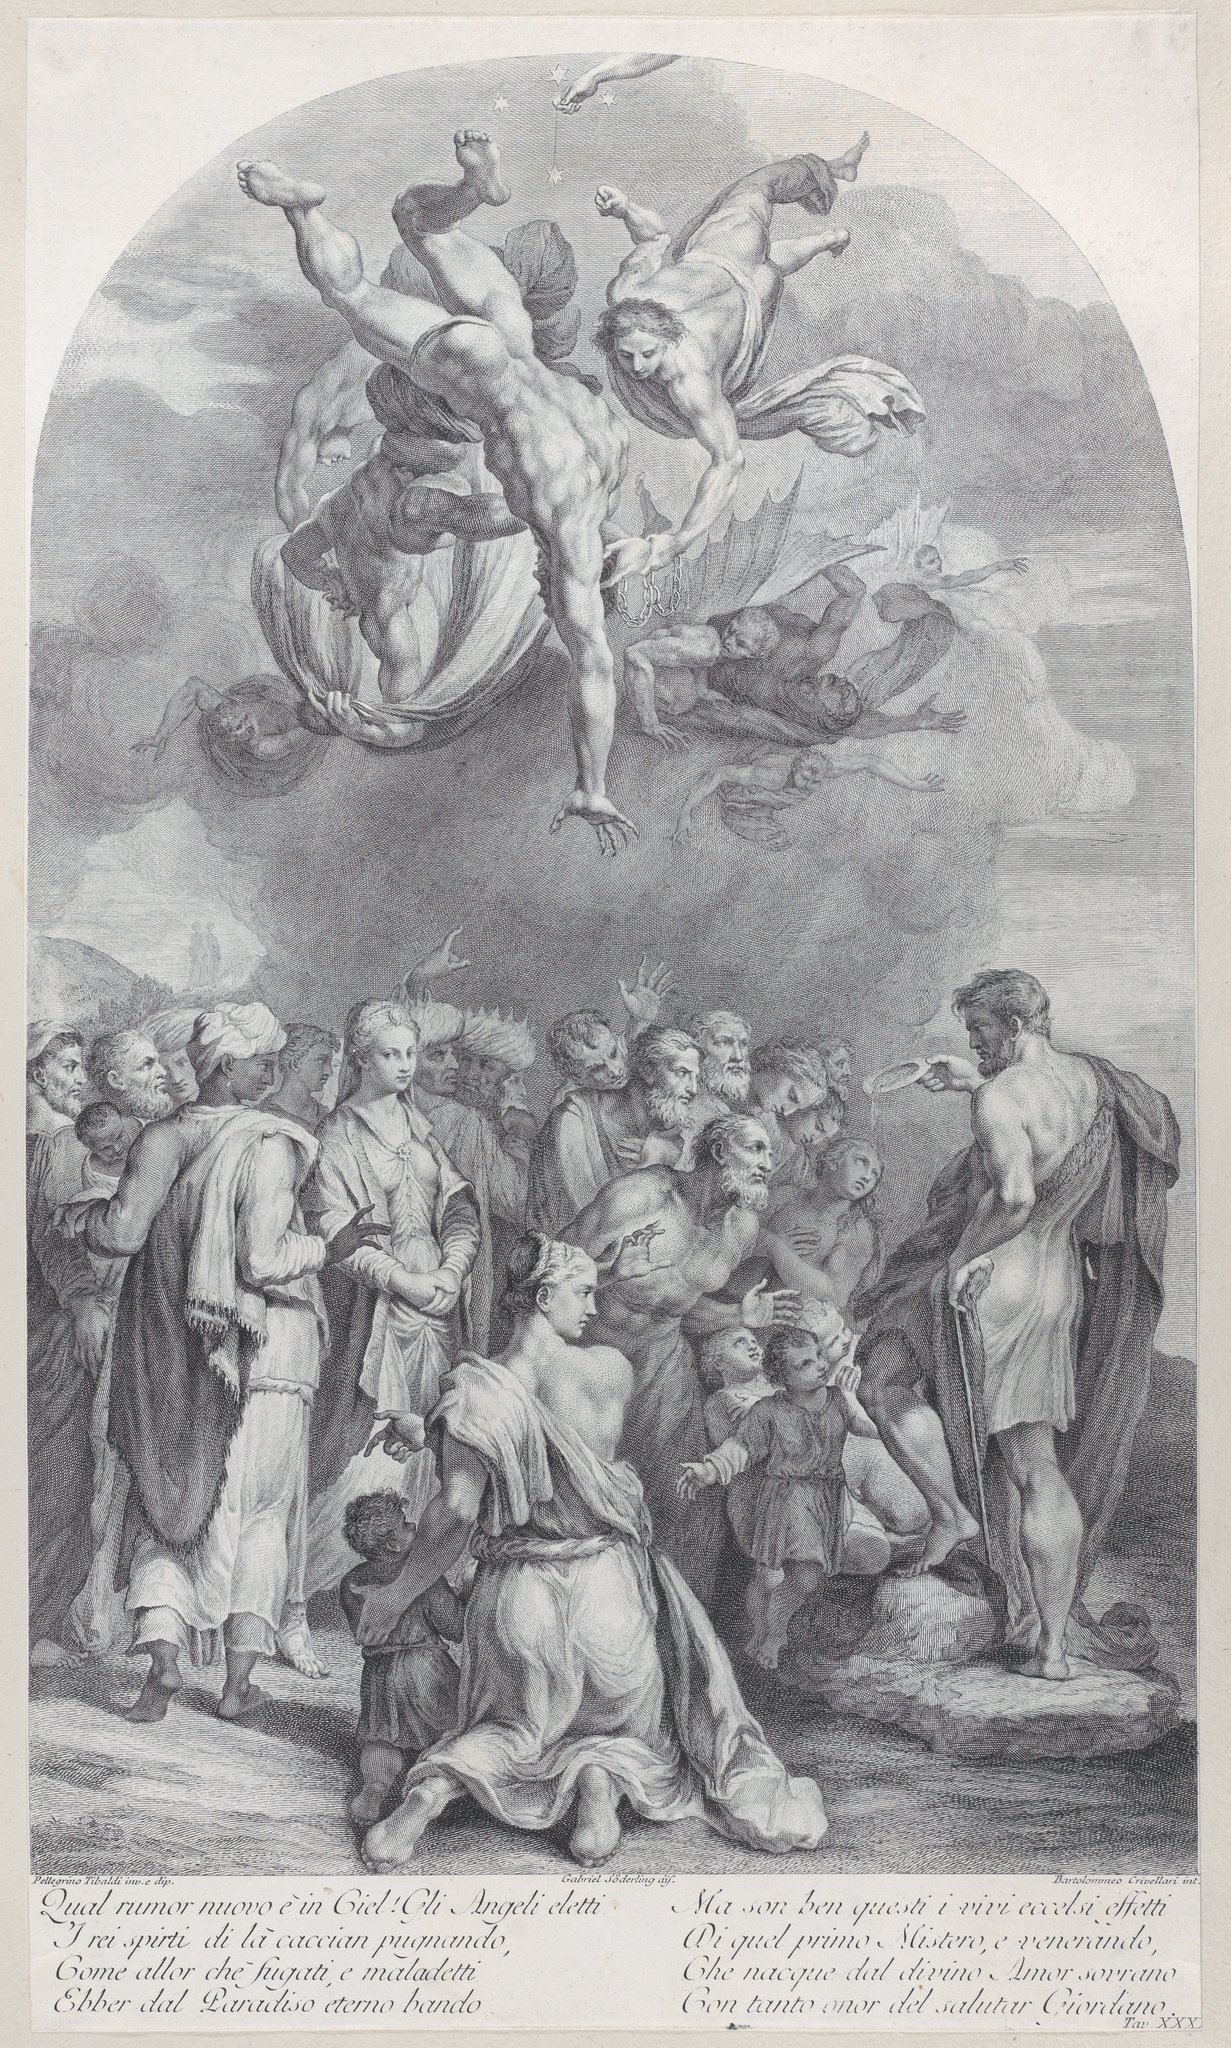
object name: print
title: Plate 41: Saint John the Baptist preaching to a large crowd and baptizing children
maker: bartolomeo crivellari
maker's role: artist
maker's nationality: italian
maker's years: 1700-1800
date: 1756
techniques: engraving, etching